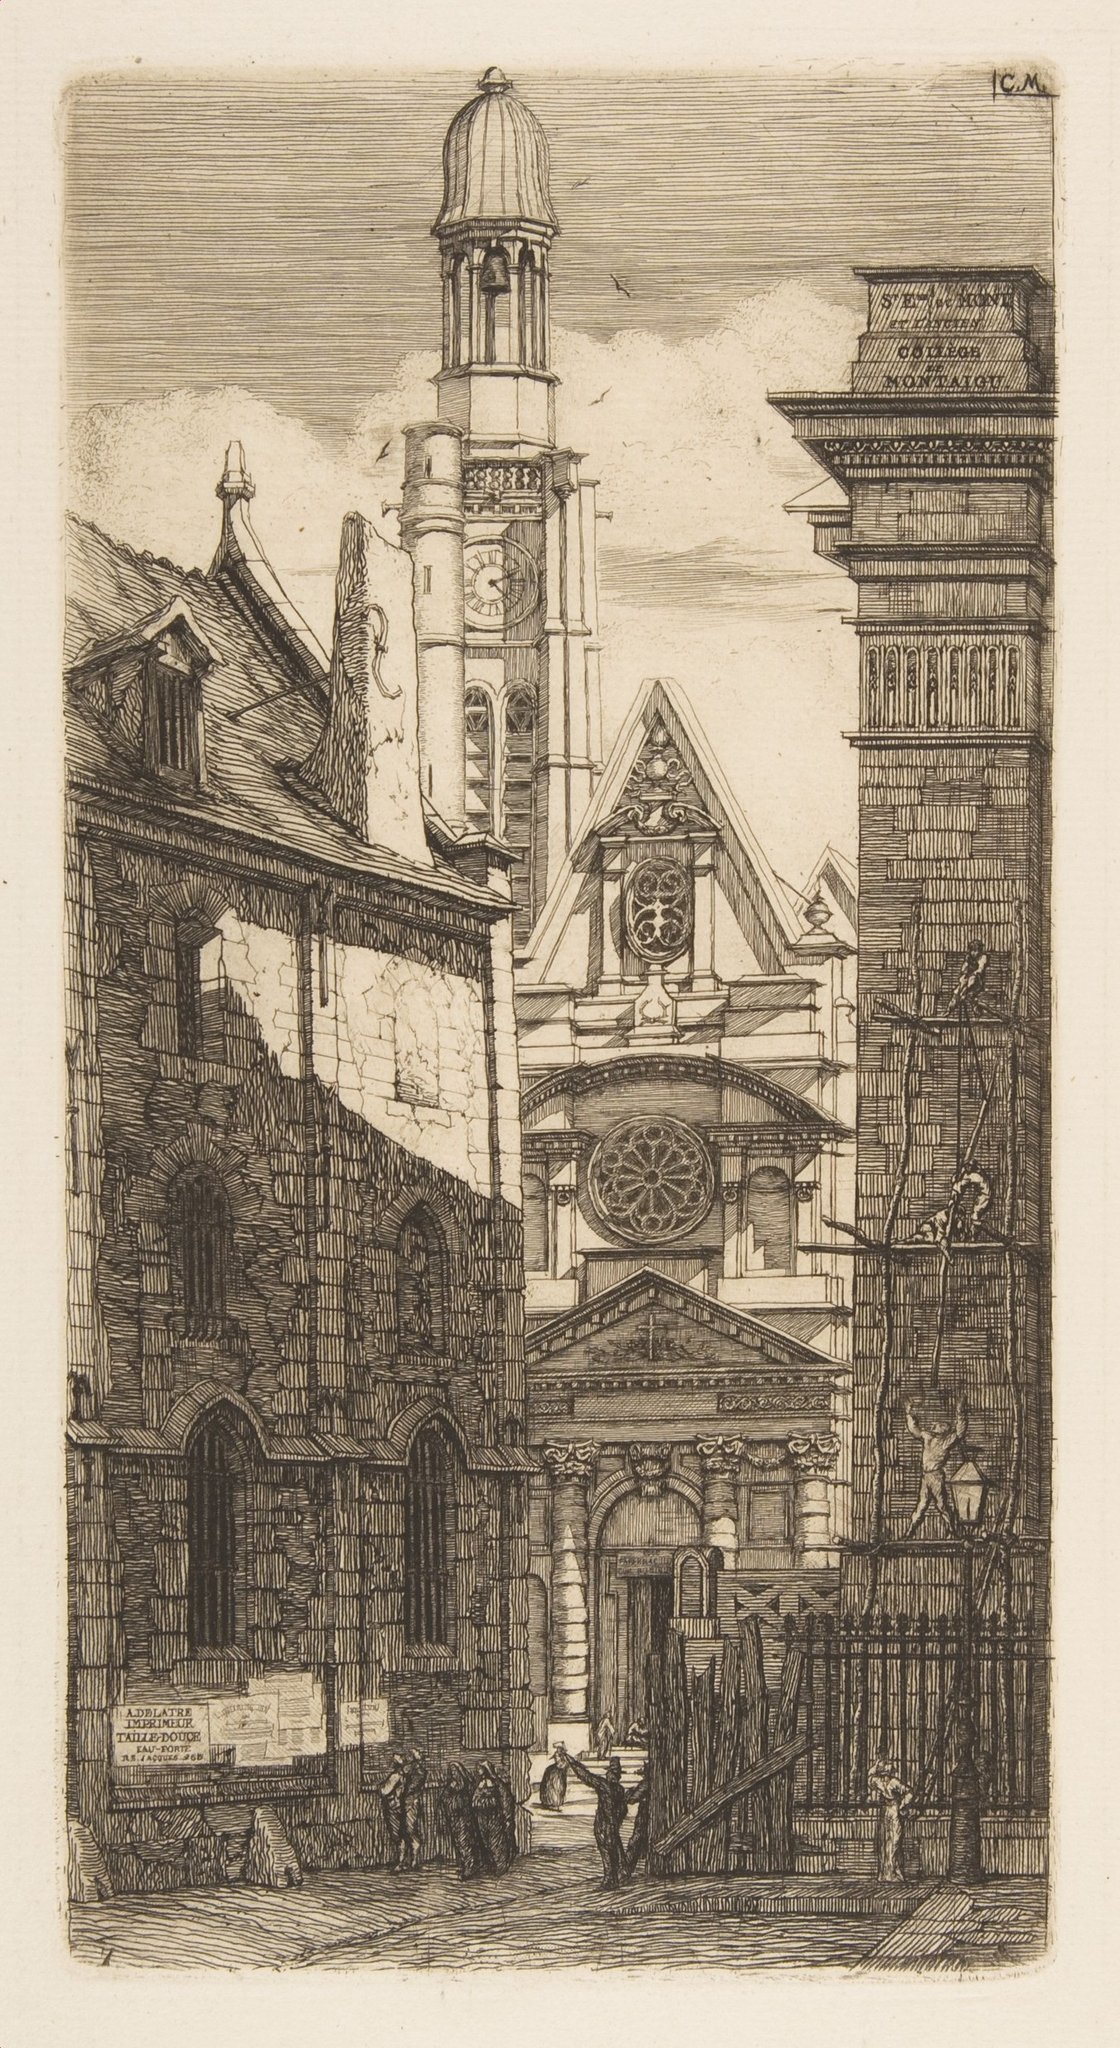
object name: print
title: The Church of St. Etienne-du-Mont, Paris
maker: charles meryon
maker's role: artist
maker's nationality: french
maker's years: 1821-1868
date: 1852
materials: paper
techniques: drypoint, etching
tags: buildings,churches,paris